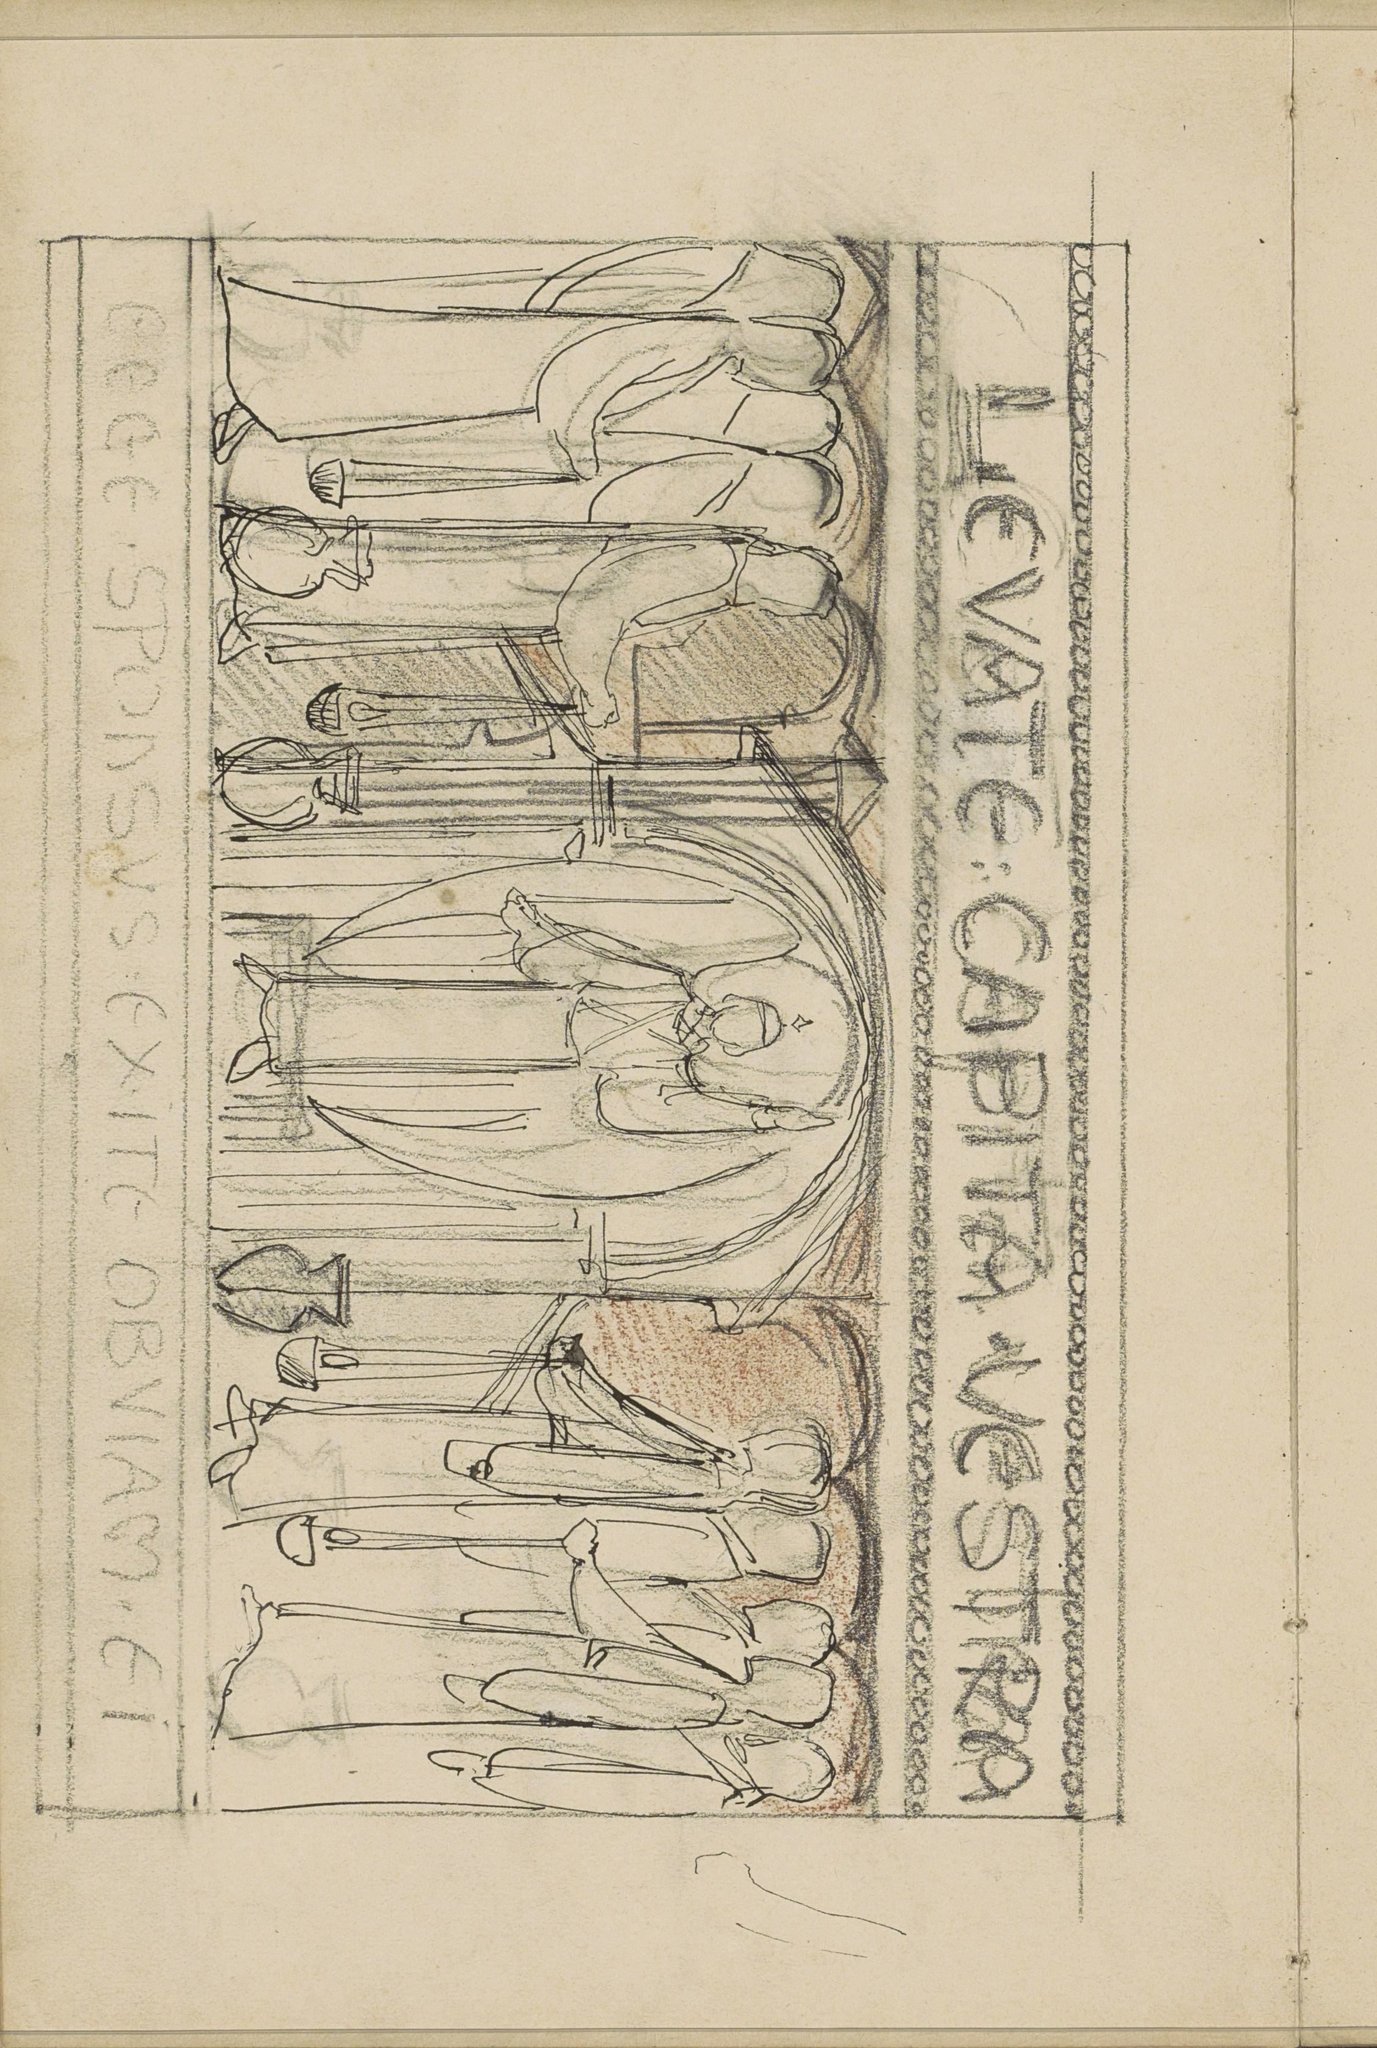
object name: sketchbook leaf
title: Ontwerp voor een wandschildering in het stadhuis te Den Bosch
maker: antoon derkinderen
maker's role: draughtsman, painter, print maker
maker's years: 1859-1925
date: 1889-1891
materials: chalk, ink, paper, pencil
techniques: pen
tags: alertness, vigilance; 'guardia', 'vigilanza', 'vigilanza per difendersi & oppugnare altri' (ripa), non-narrative representations of the wise and the foolish virgins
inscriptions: annotation: ‘LEVATE CAPITA VESTRA/ ECCE SPONSUS EXITE OBVIAM EI’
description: Een engel maant maagden tot waakzaamheid. Blad 28 verso uit een schetsboek met 33 bladen.